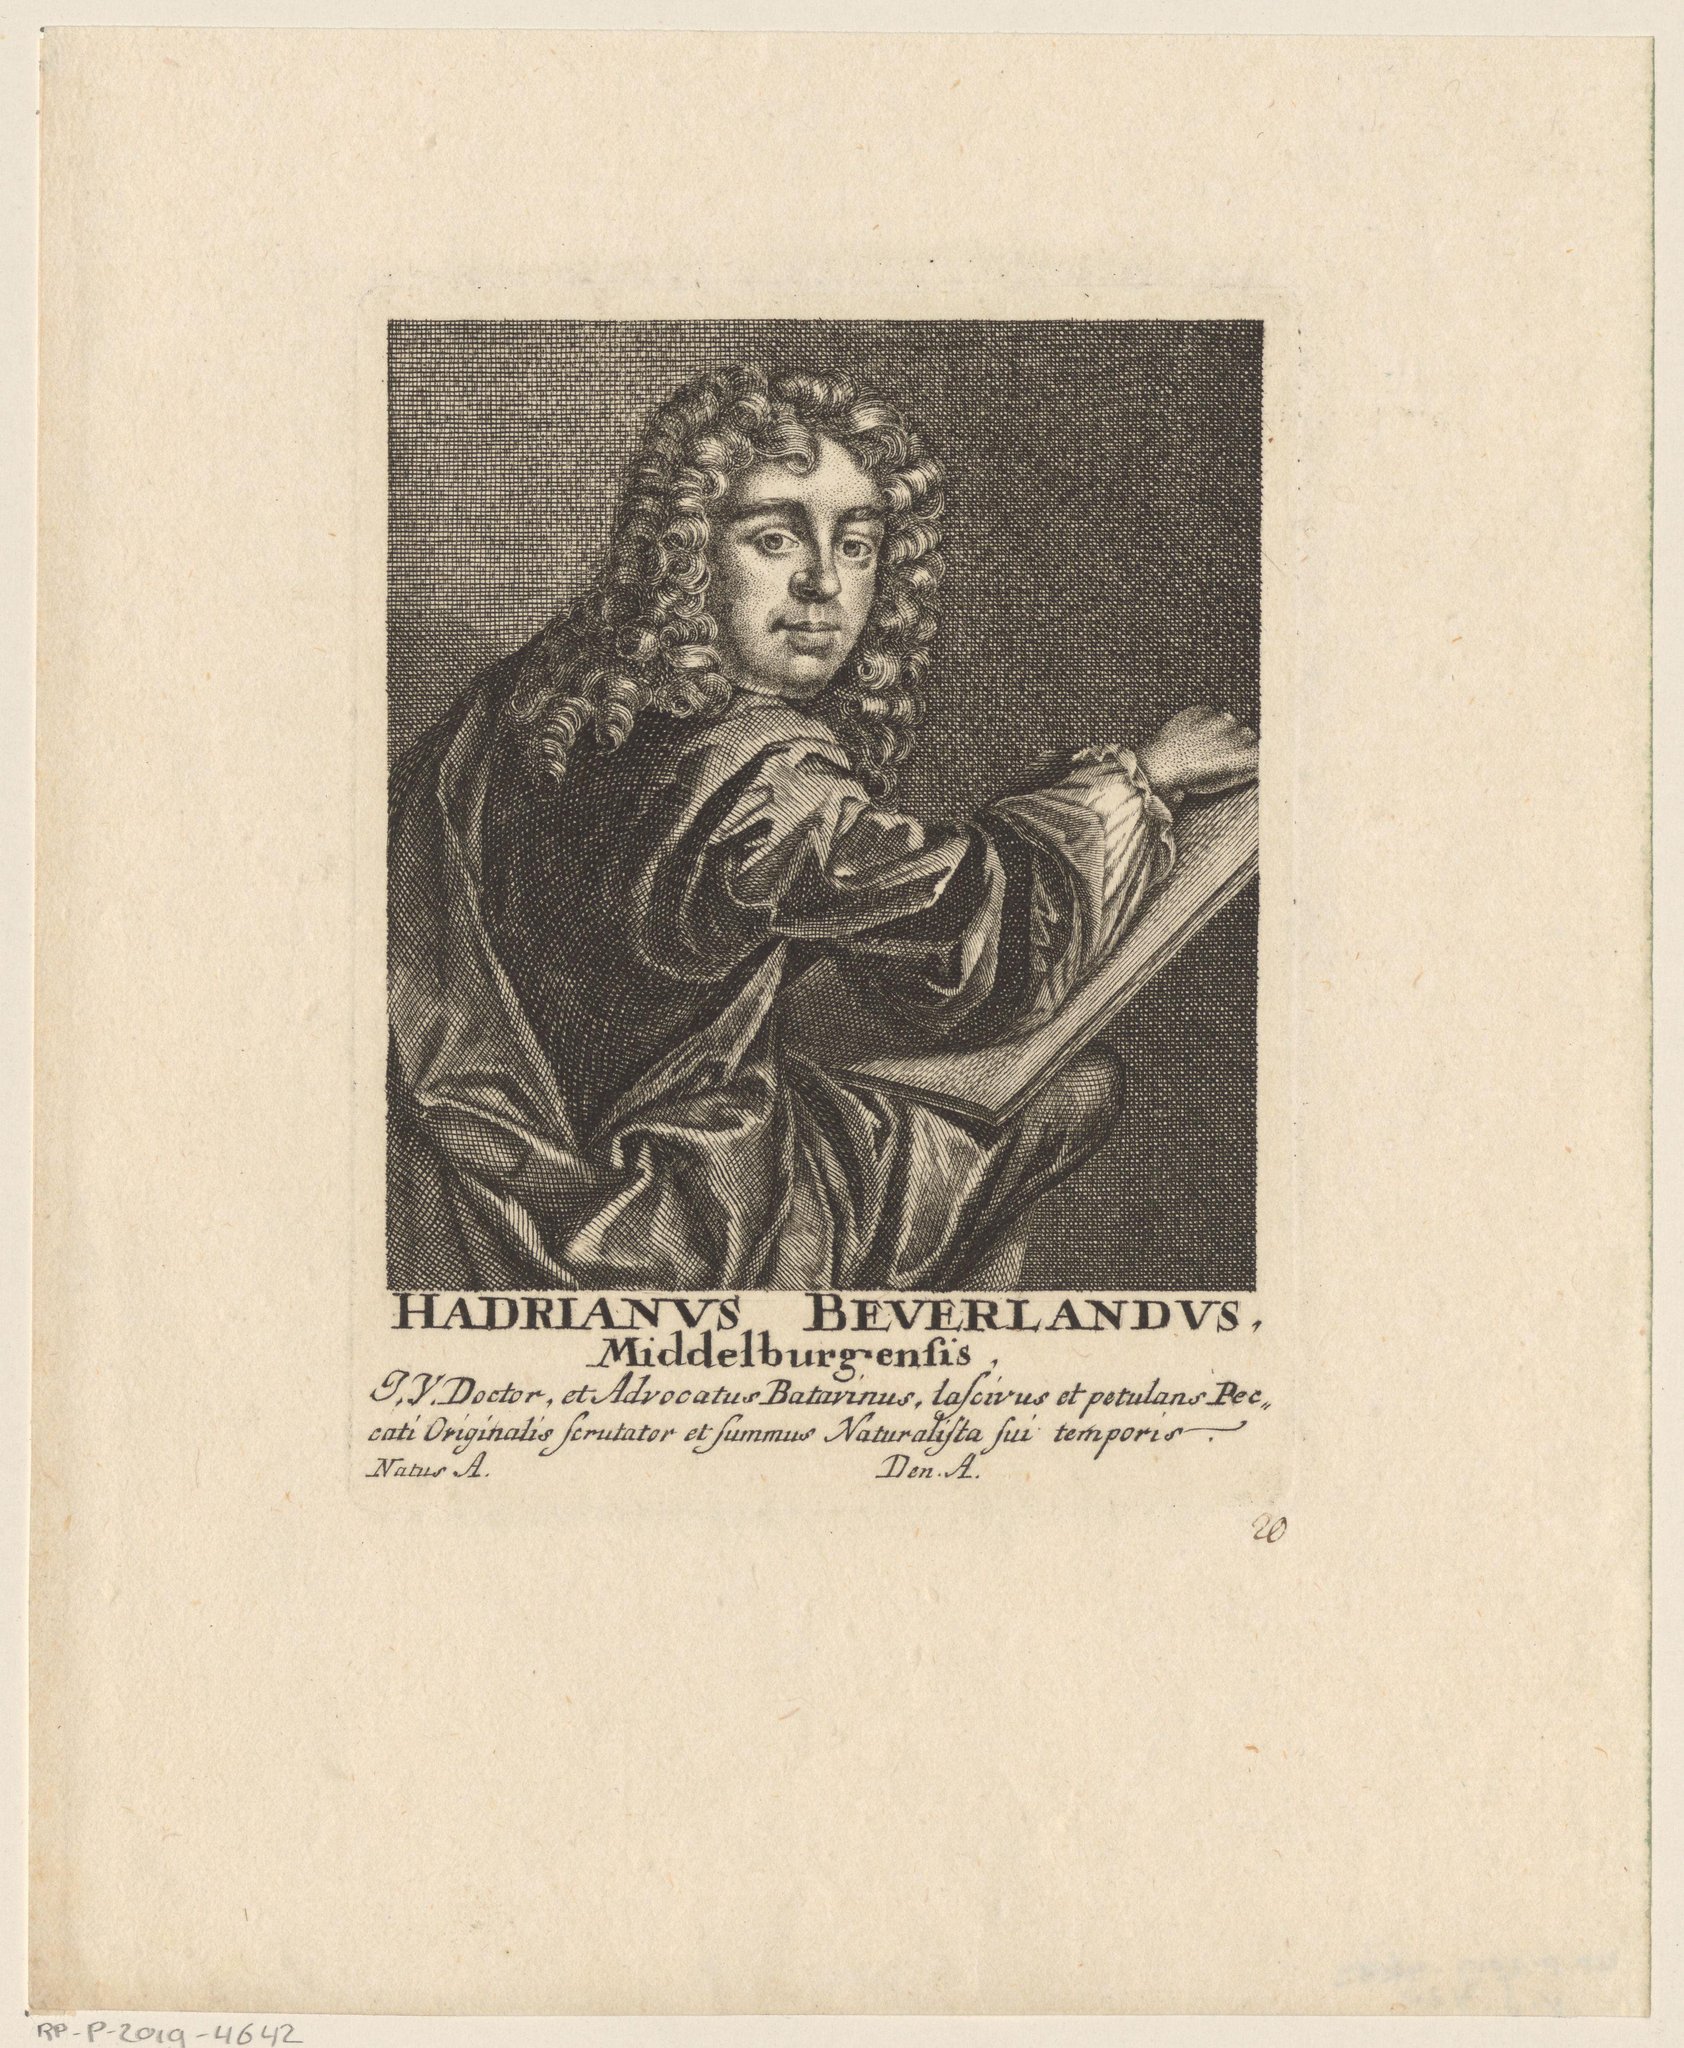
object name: print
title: Icones virorum omnium ordinum eruditione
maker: Anonymous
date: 1725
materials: paper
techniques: engraving, etching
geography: nuremberg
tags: middelburg, historical persons, draughtsman at work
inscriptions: inscription: ‘20’